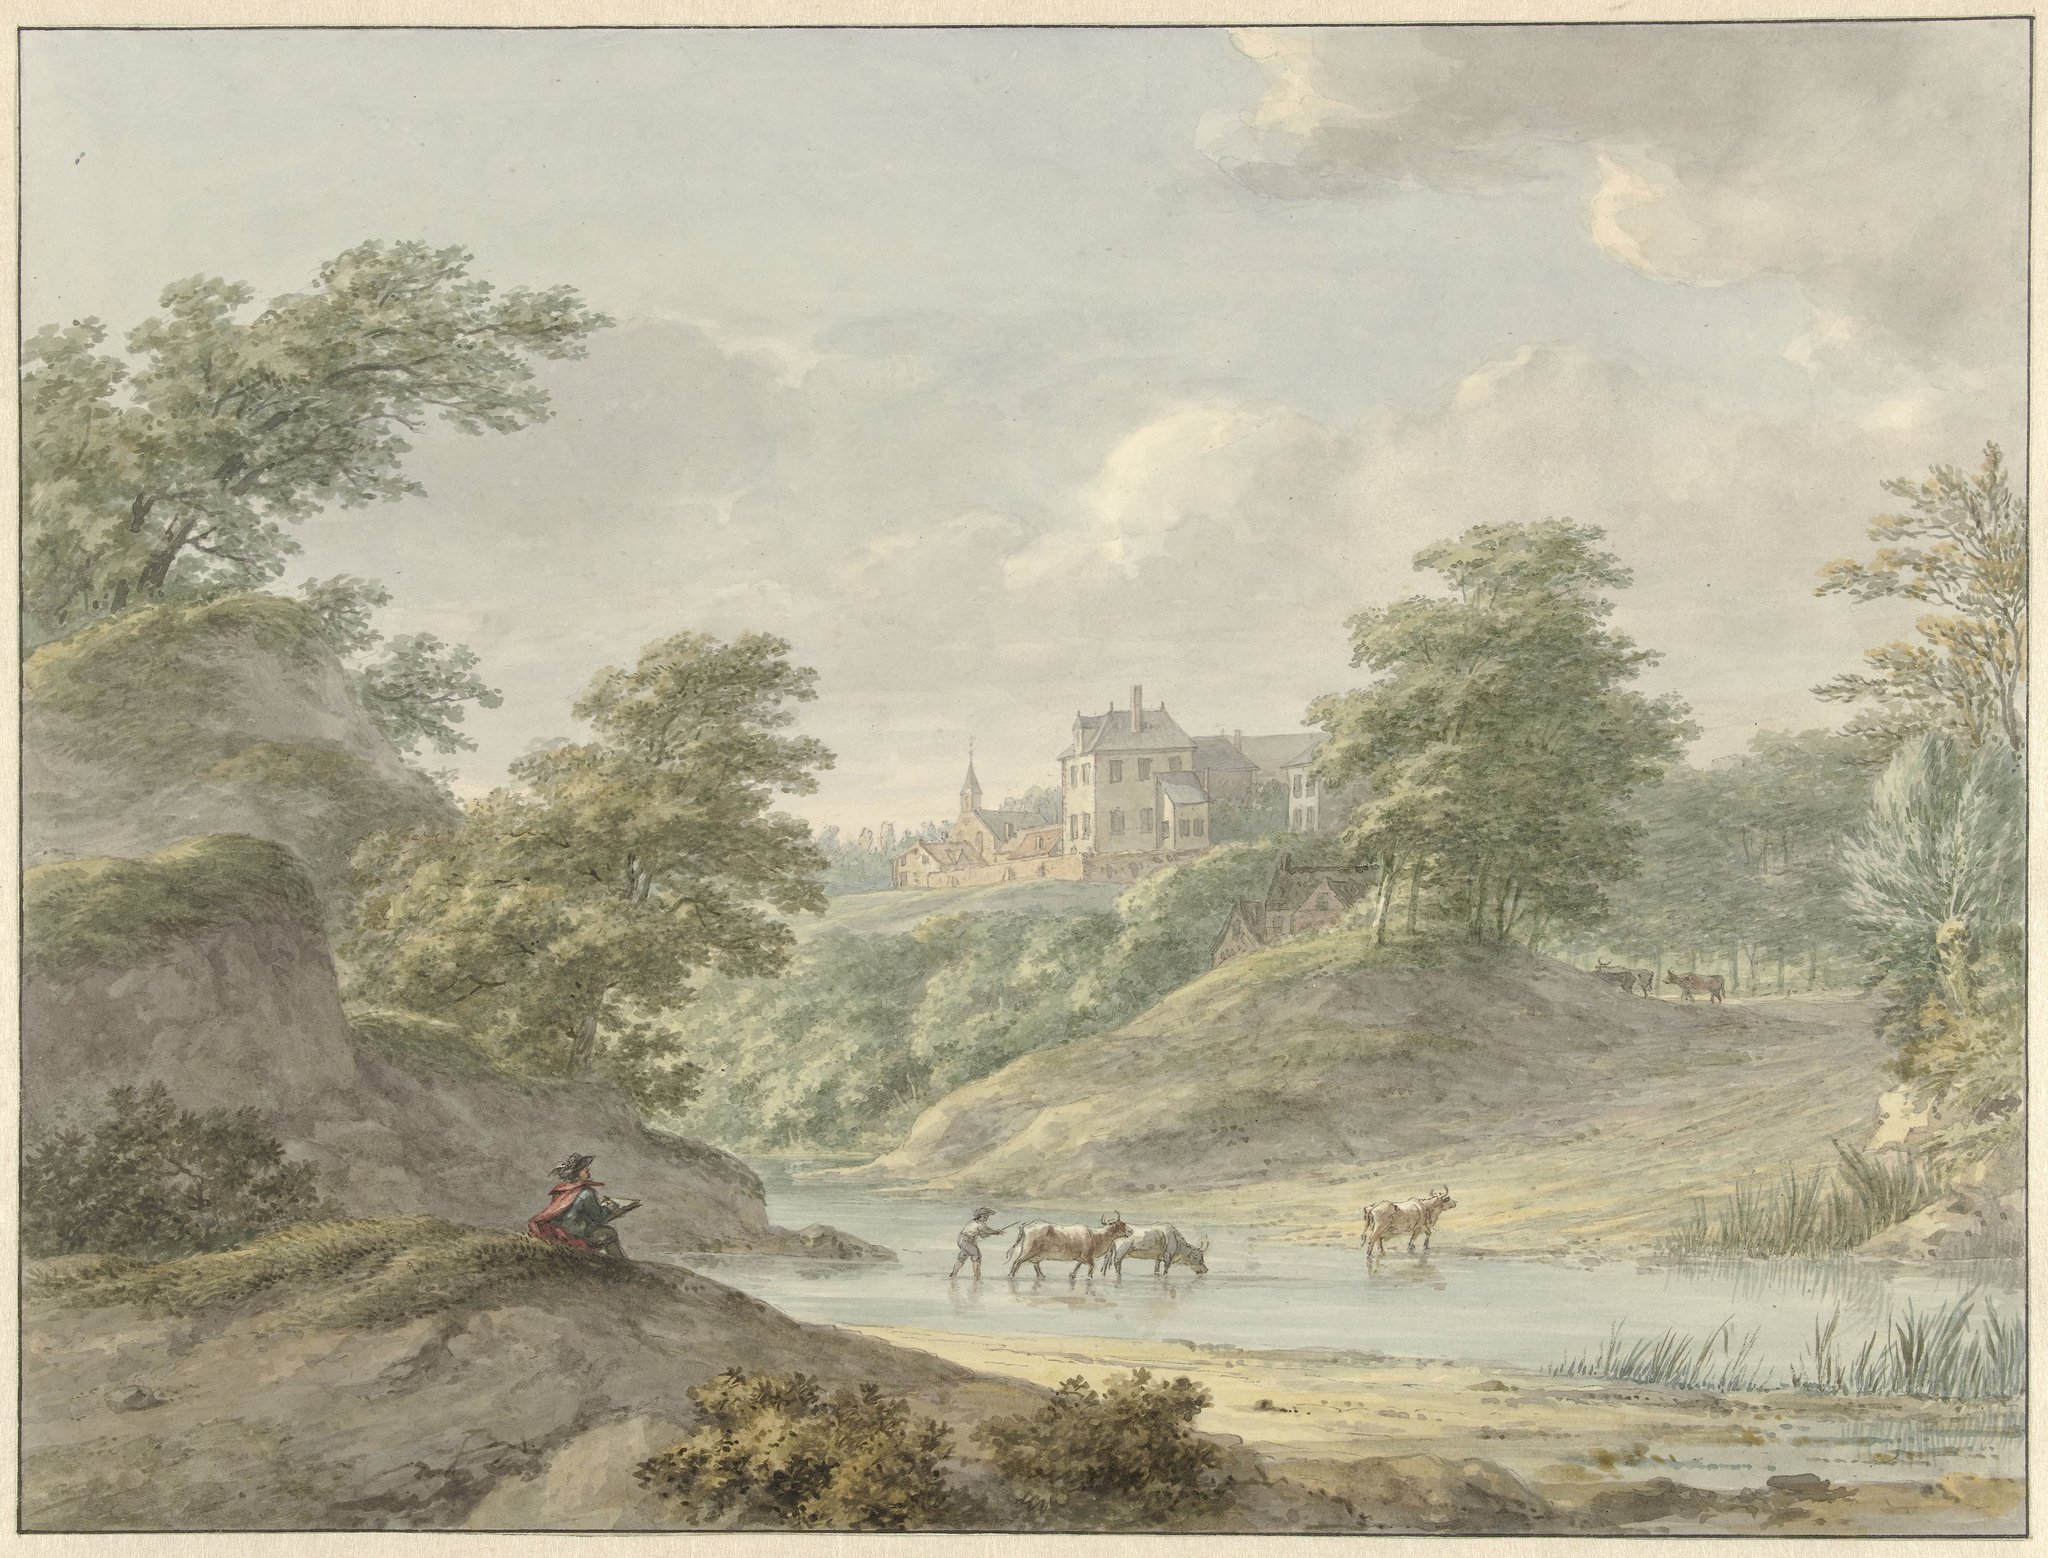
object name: drawing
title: Landschap met zittende tekenaar en kasteel aan water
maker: hermanus numan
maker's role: draughtsman, painter, print maker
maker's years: 1744-1820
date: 1754-1820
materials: ink, paper, pencil, watercolor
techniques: brush, pen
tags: draughtsman at work - cc - out of doors